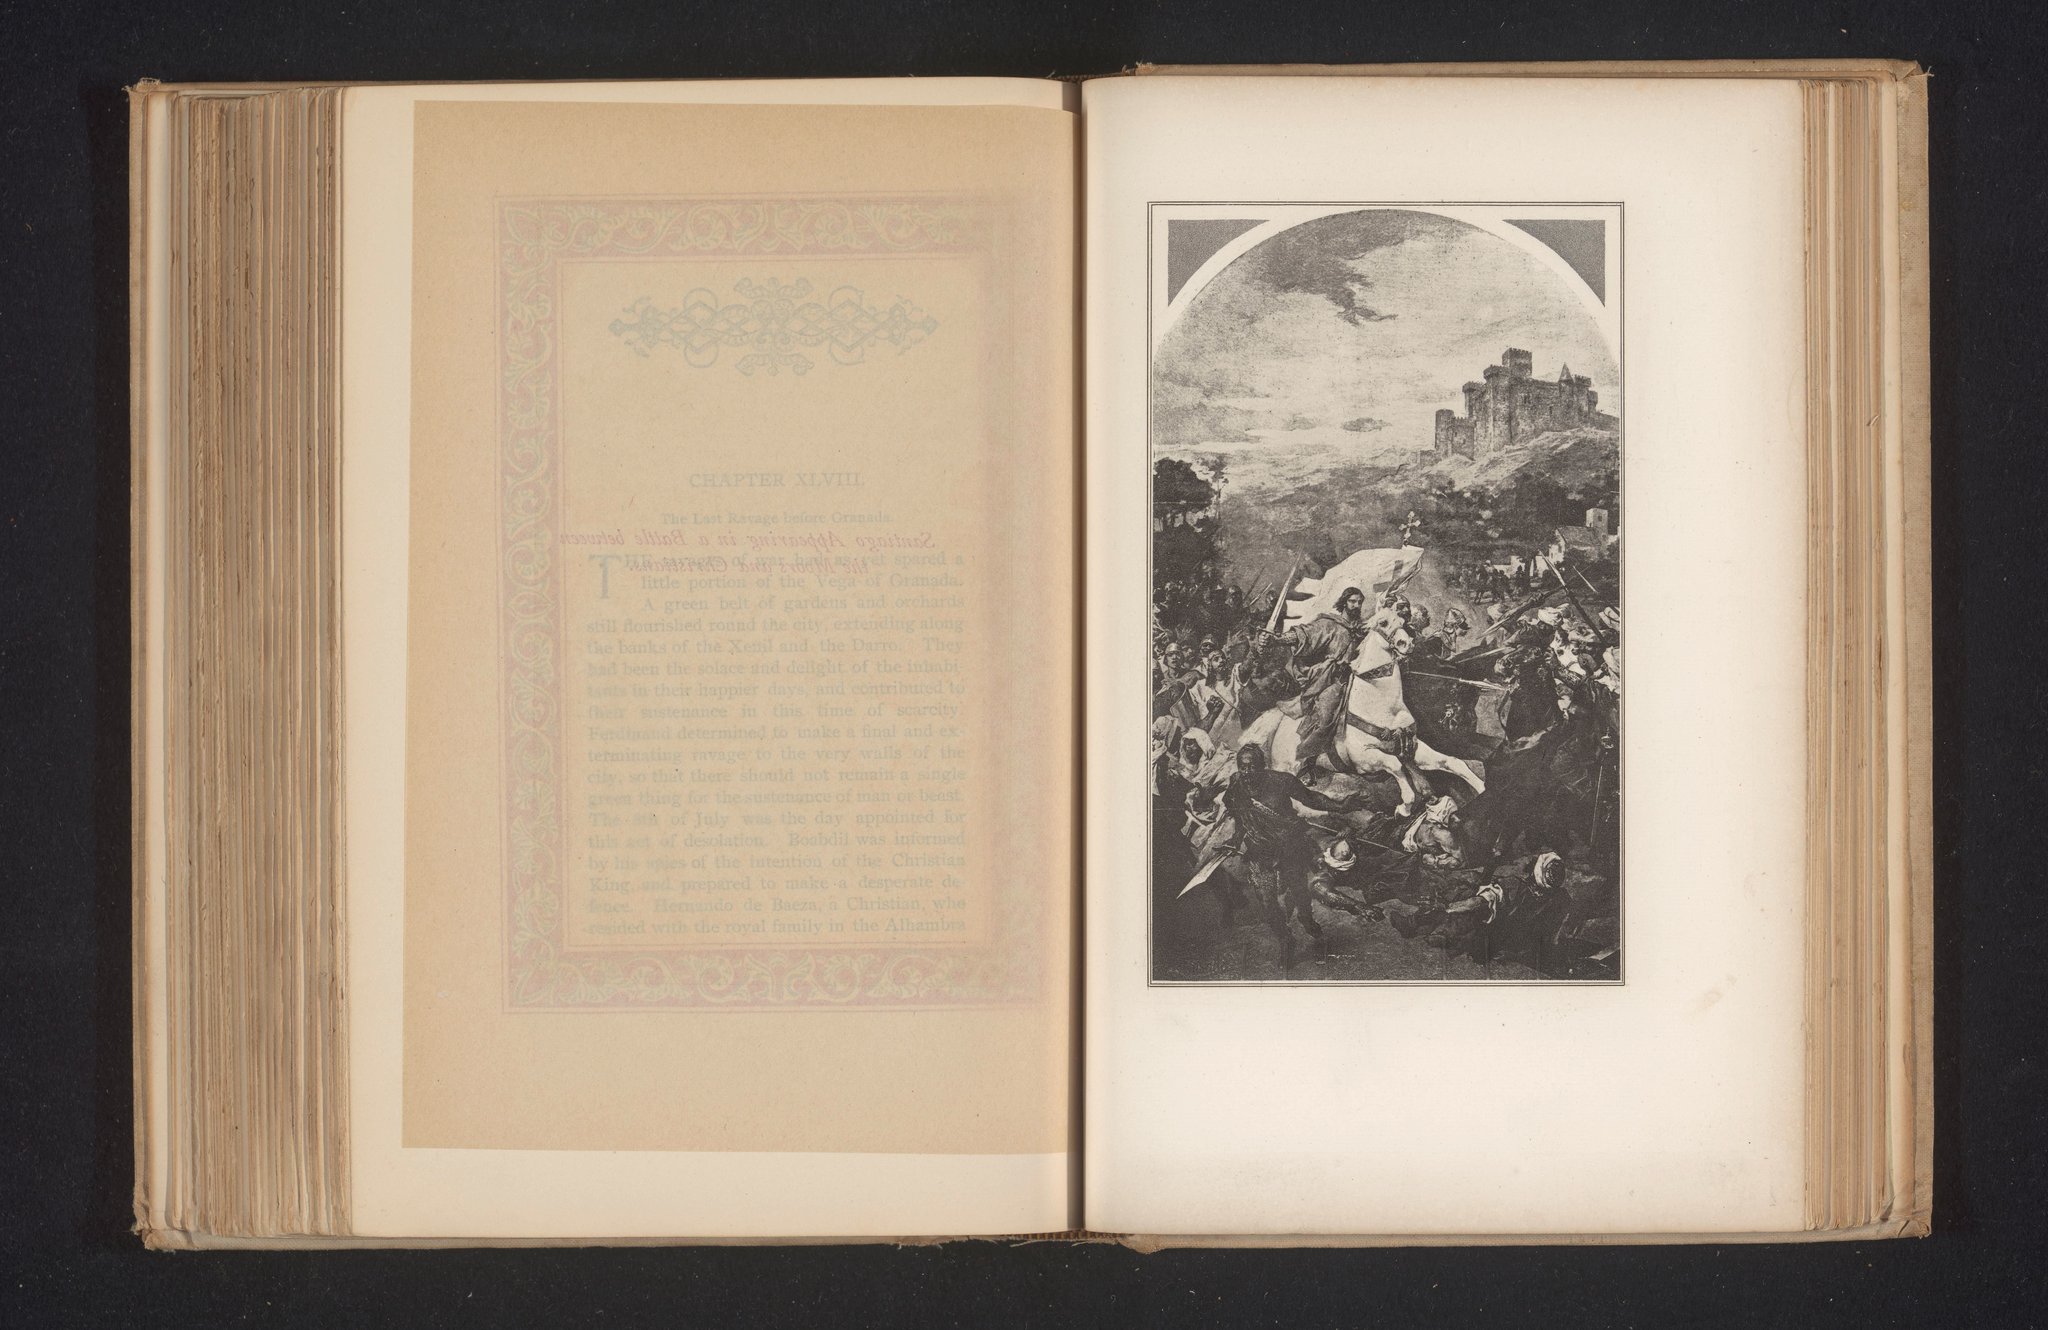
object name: photomechanical print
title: Santiago Appearing in a Battle between the Moors and Christians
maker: Anonymous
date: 1883-1893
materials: paper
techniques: photoaquatint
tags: life and acts of james the great (the elder)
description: In deze context wordt Jakobus de Meerdere de morenslachter genoemd.